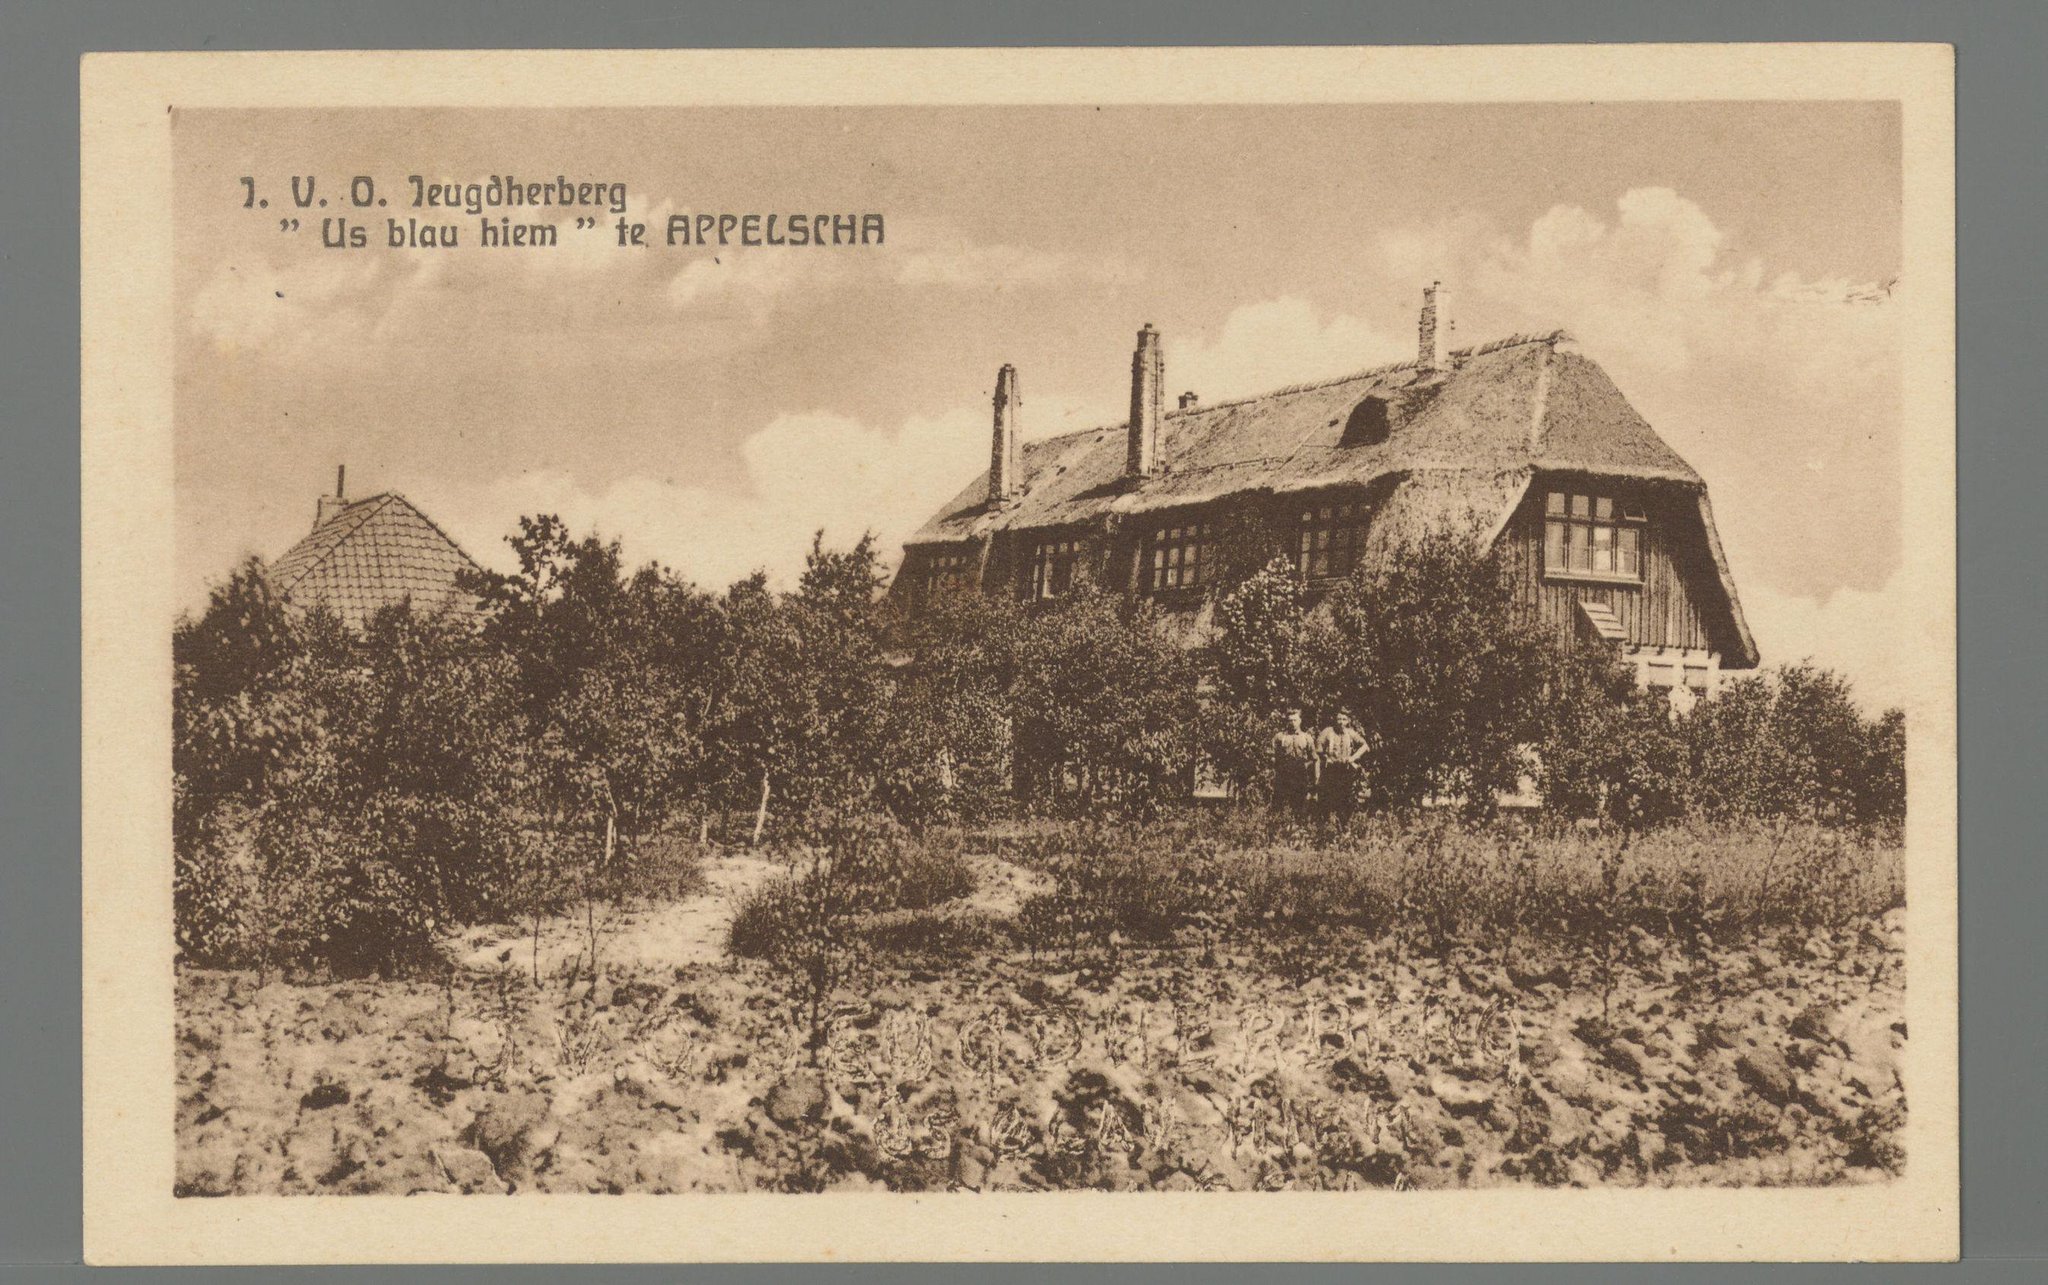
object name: ansichtkaart, prentbriefkaart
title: J. V. O. Jeugdberg "Us blau hiem" te APPELSCHA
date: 1919-1930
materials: cardboard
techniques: photograph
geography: appelscha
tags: hotel, hostelry, inn